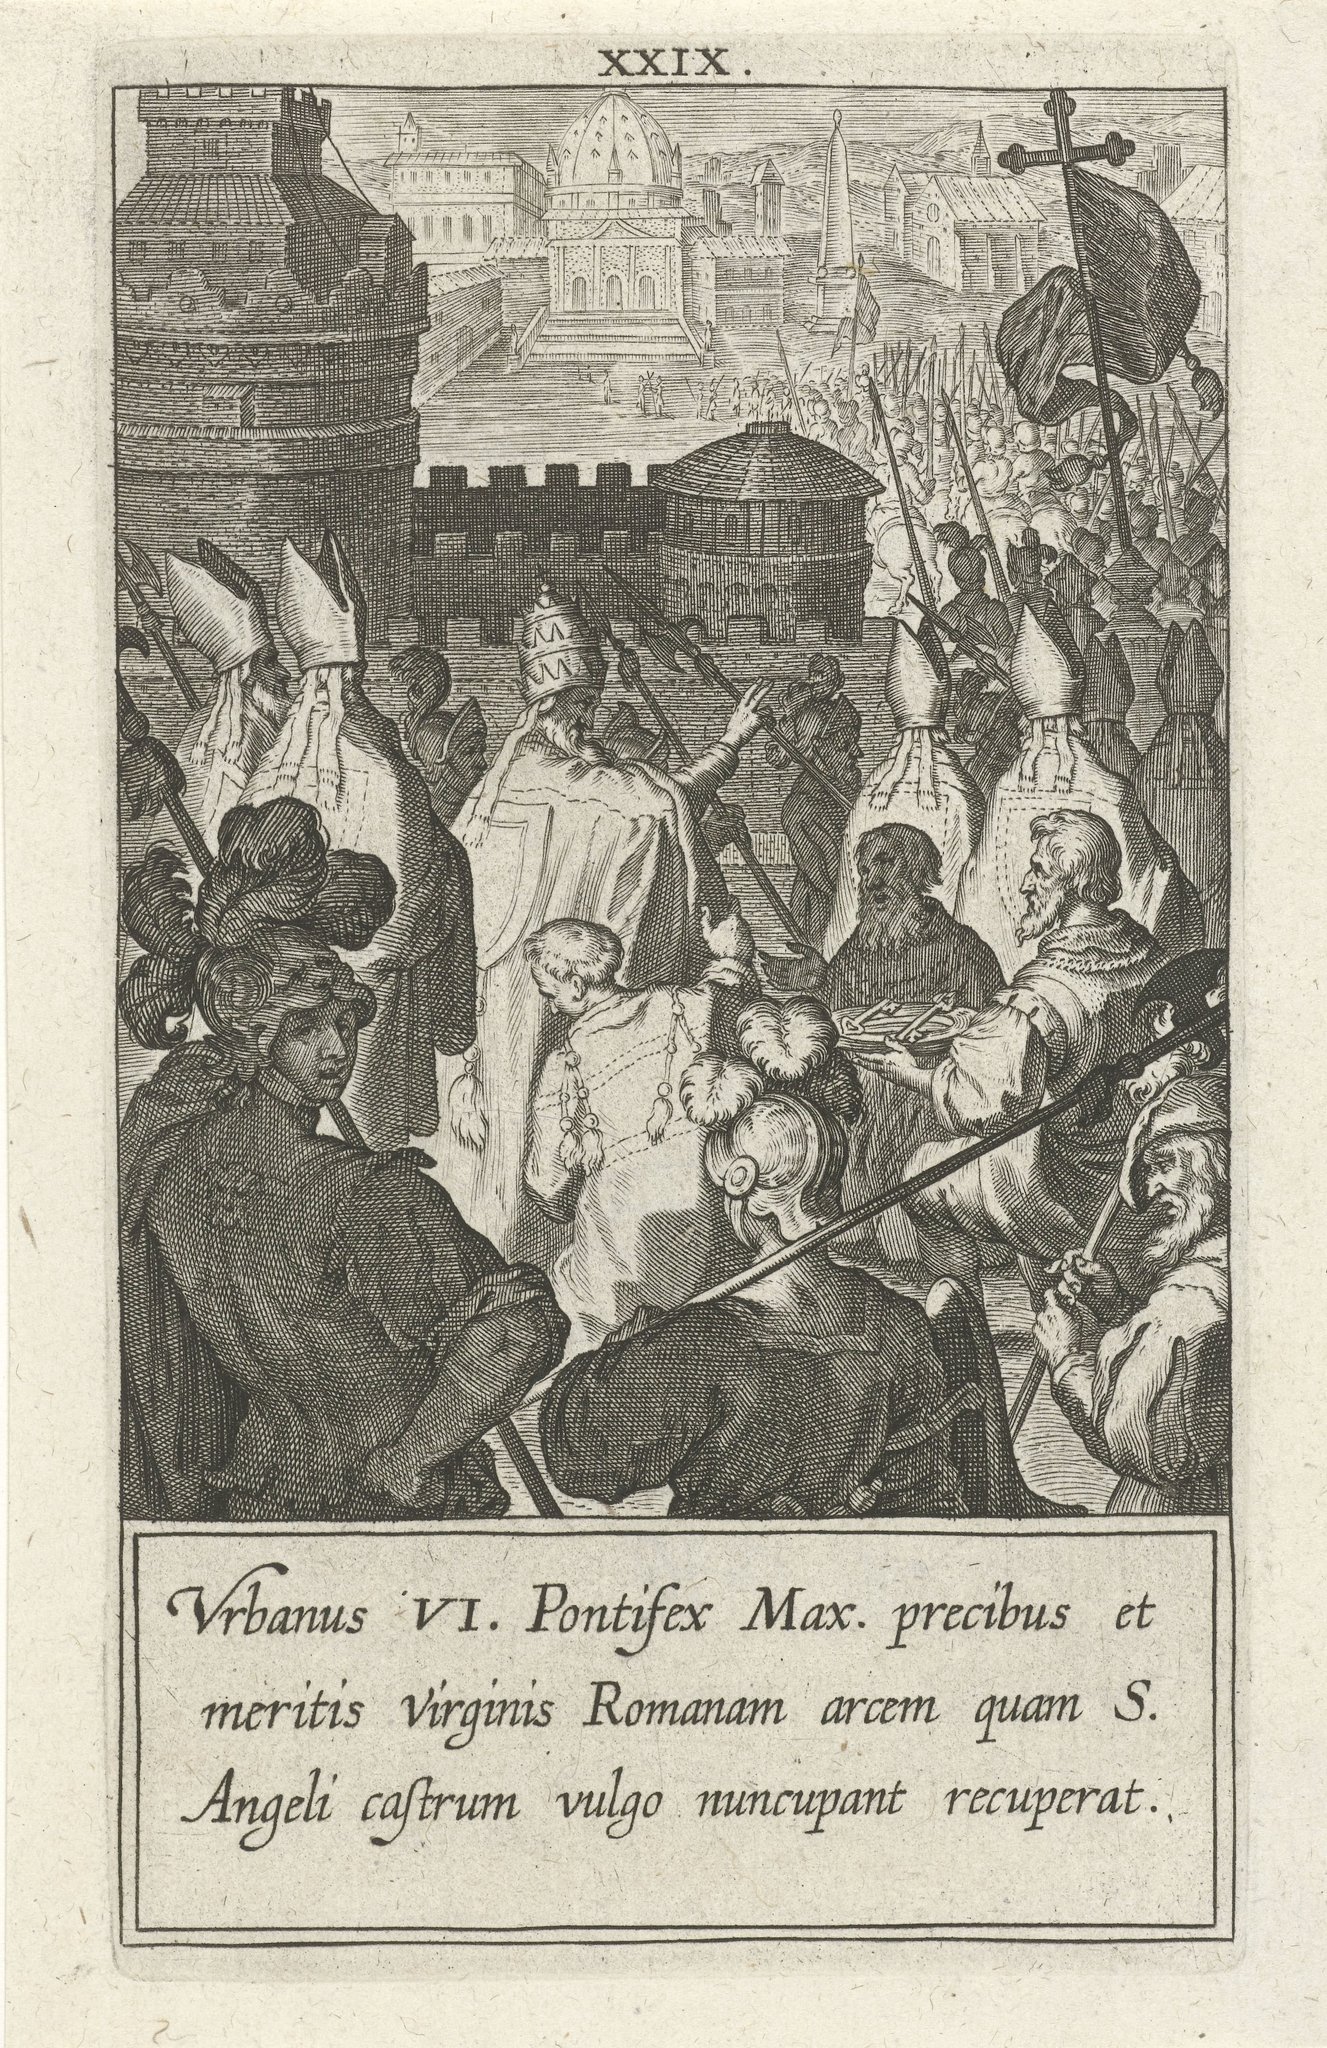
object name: print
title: Het leven van de H. Catharina van Siena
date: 1603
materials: paper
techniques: engraving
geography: southern netherlands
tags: naples, rome, the virgin and dominican tertiary, catherine of siena; possible attributes: book, cross, crown of thorns, crucifix, demon under foot, heart (with cross), lily, plague-stricken, ring, rosary, stigmata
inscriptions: collector's mark: Lugt 2228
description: Onder druk van het Romeinse volk wordt Urbanus VI tot paus gekozen en neemt nu met een feestelijke intocht zijn intrek in de engelenburcht. Deel van een serie over Catharina van Siena bestaande uit een titelprent, een portret en 32 genummerde scènes uit haar leven.